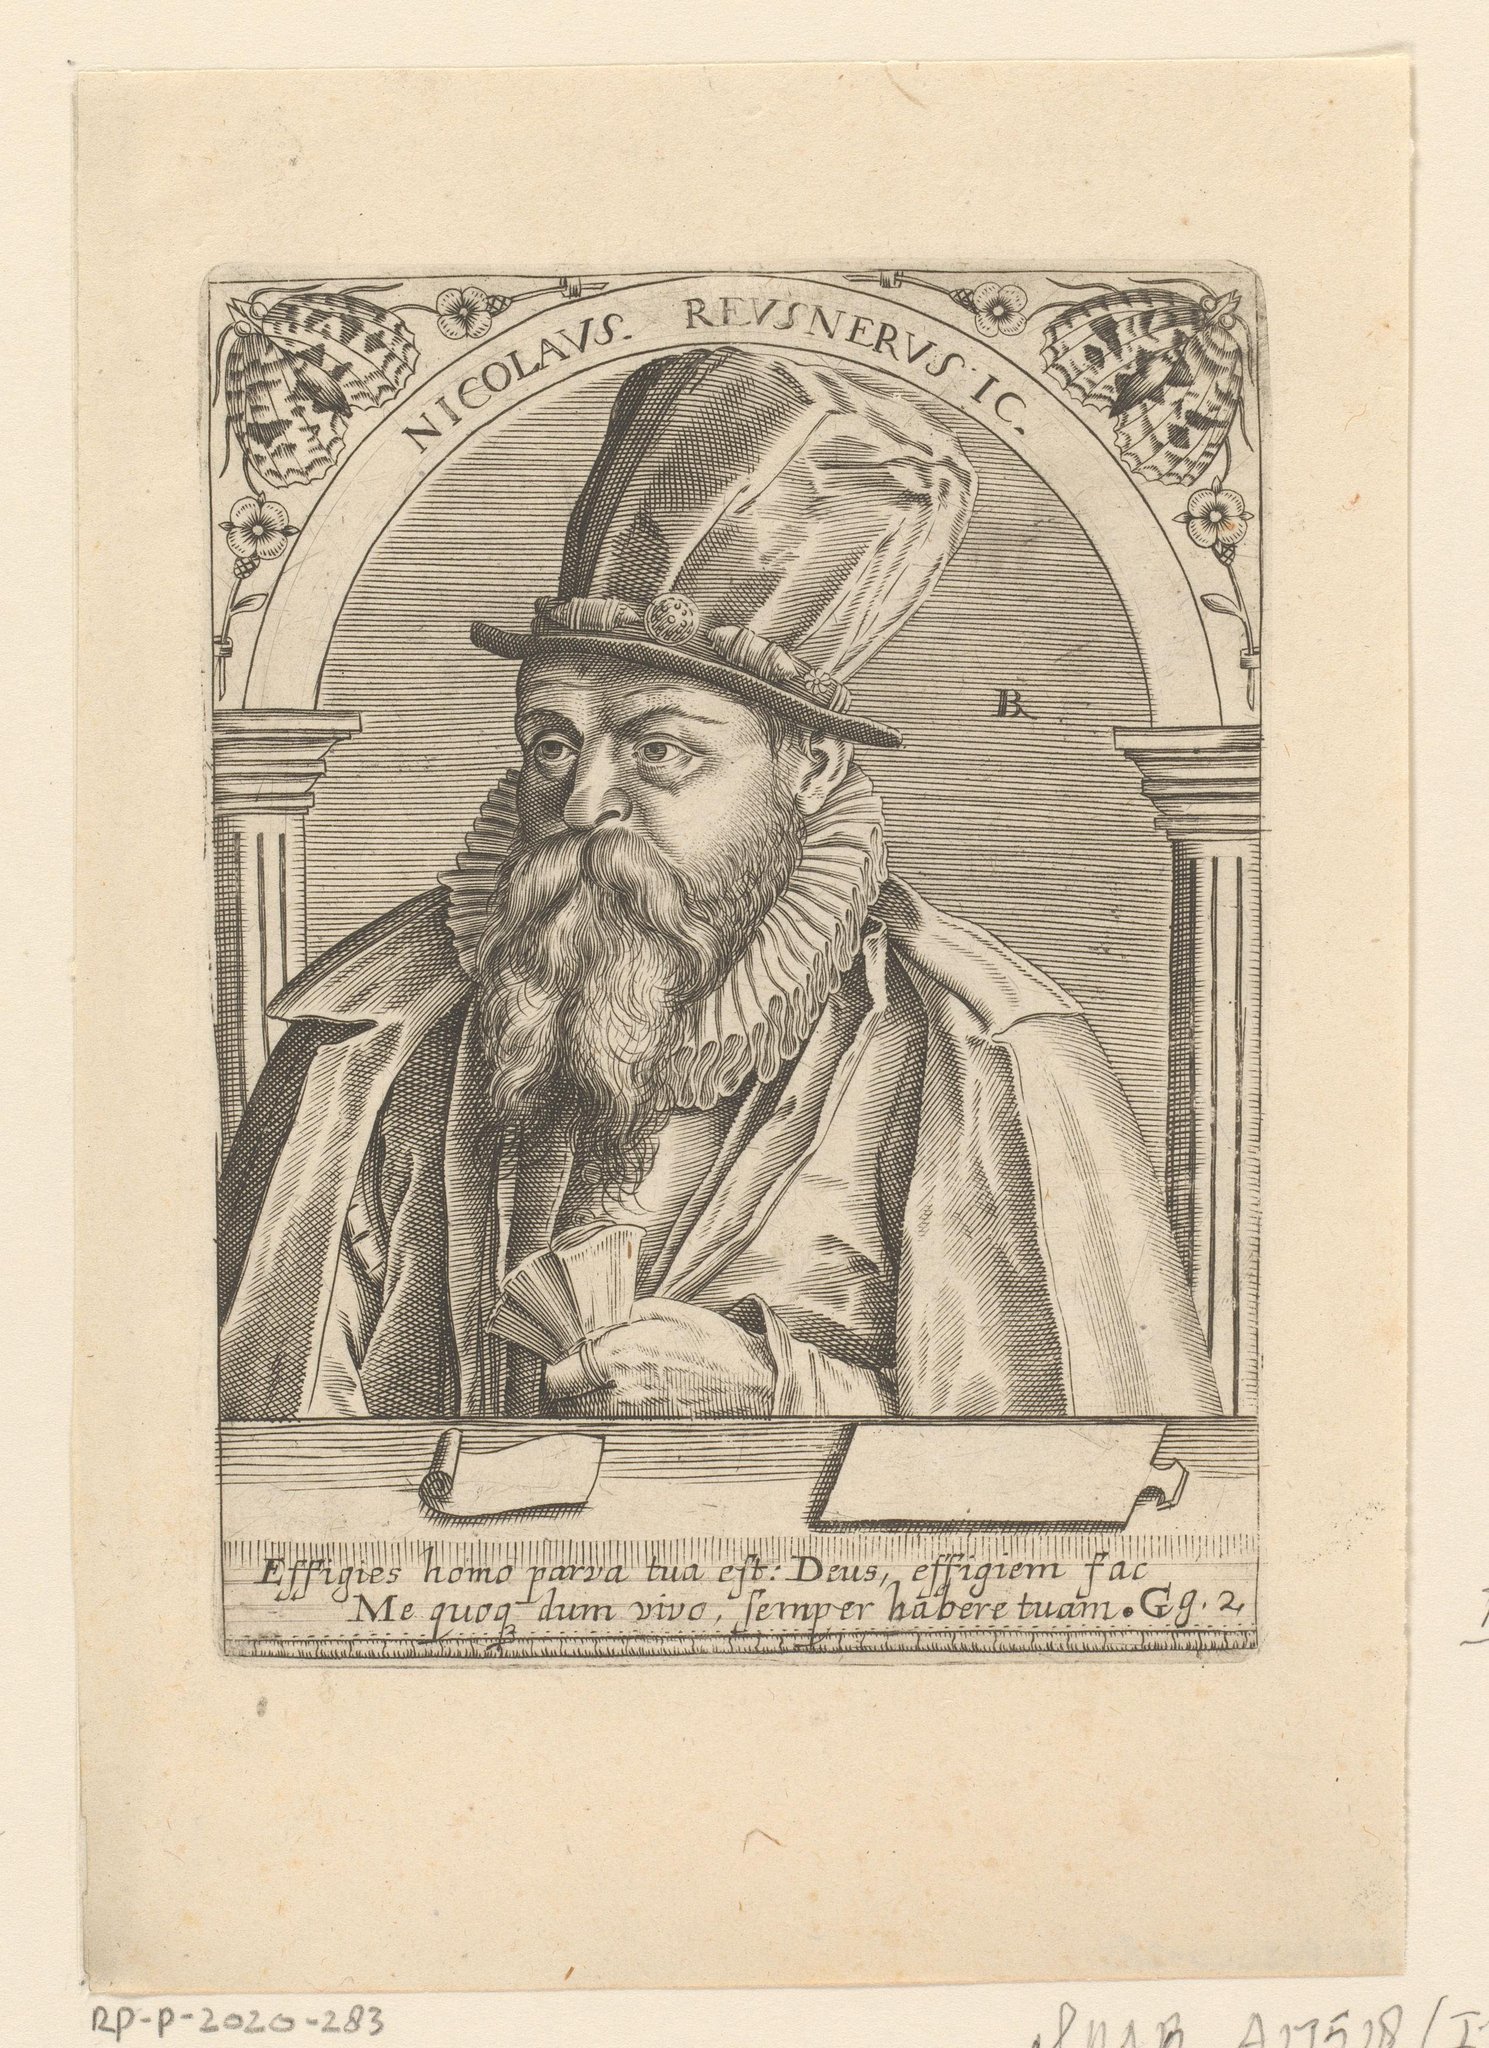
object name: book illustration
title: Nicolaus. Reusnerus' ic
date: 1650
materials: paper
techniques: engraving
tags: nikolaus reusner, historical persons, publishing, publisher, law and jurisprudence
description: Prent gebruikt in: Boissard, Jean Jacques. Bibliotheca chalcographica. 8 dln. Frankfurt am Main: Johannes Ammon, 1650-1652. Ook gebruikt in latere edities. Eerdere staat van prent verschenen in: Boissard, Jean Jacques. Icones quinquaginta virorum illustrium doctrina & eruditione praestantium ad vivum effictae. 4 dln. Frankfurt am Main: s.n., 1597-1599. Mogelijk ook gebruikt in latere edities.